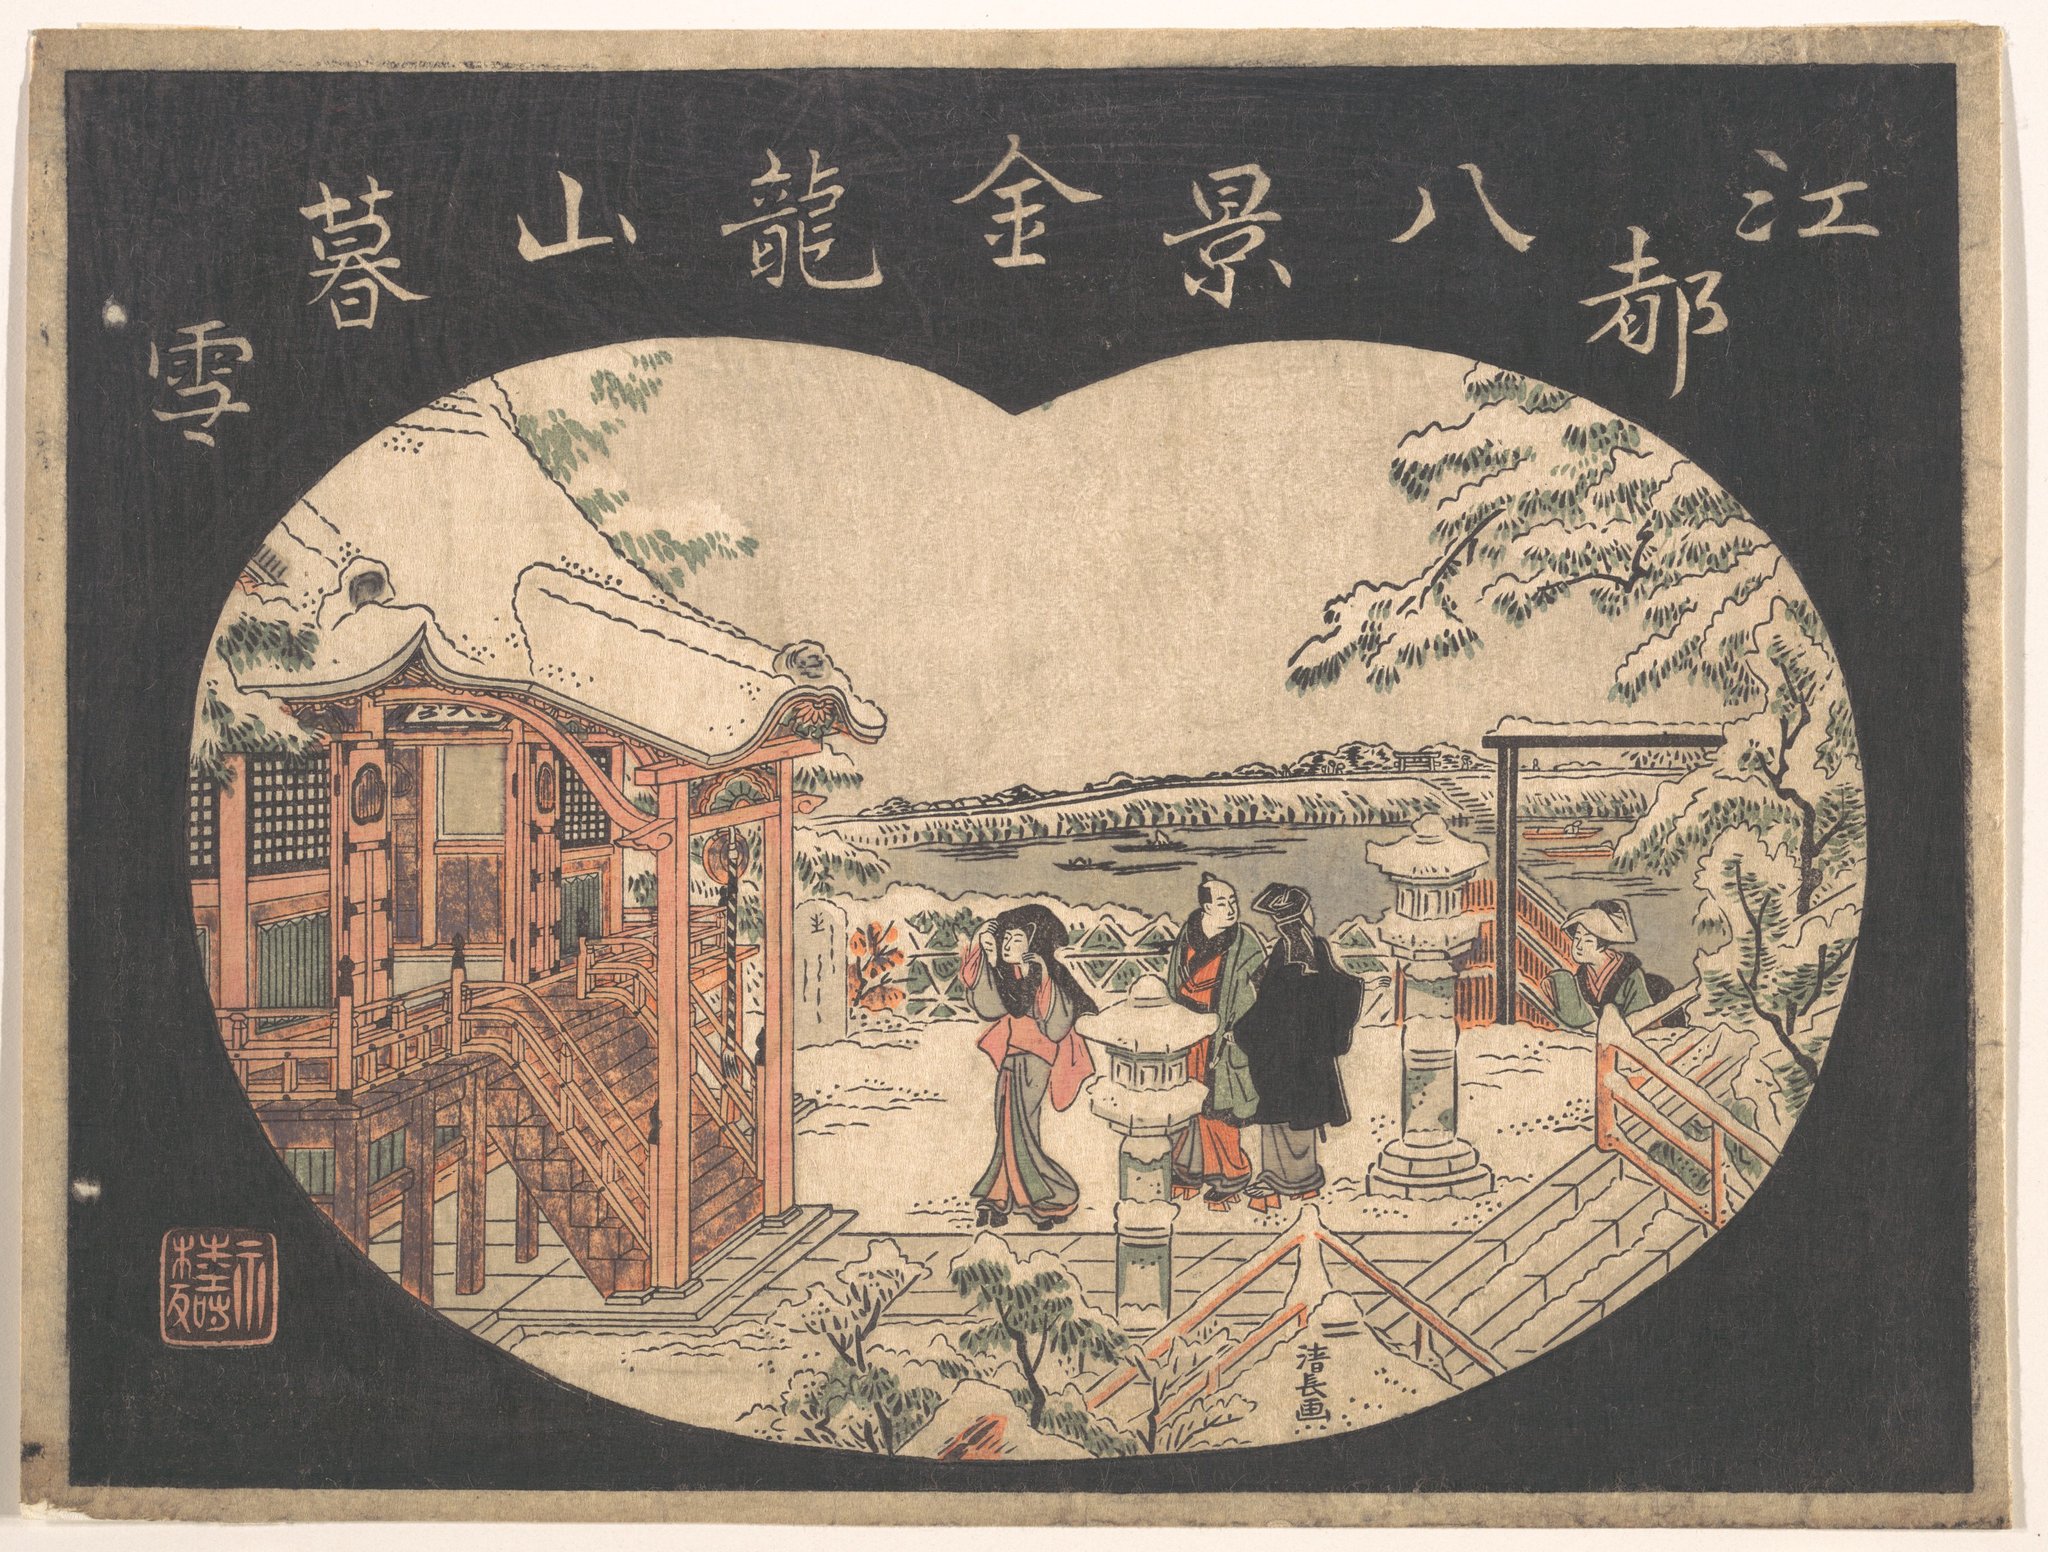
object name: print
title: Snow Scene with Figures Outside a Temple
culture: japanese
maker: torii kiyonaga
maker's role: artist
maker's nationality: japanese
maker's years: 1752-1815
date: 1742-1815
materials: ink, paper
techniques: woodblock print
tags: temples,men,women,trees,snow